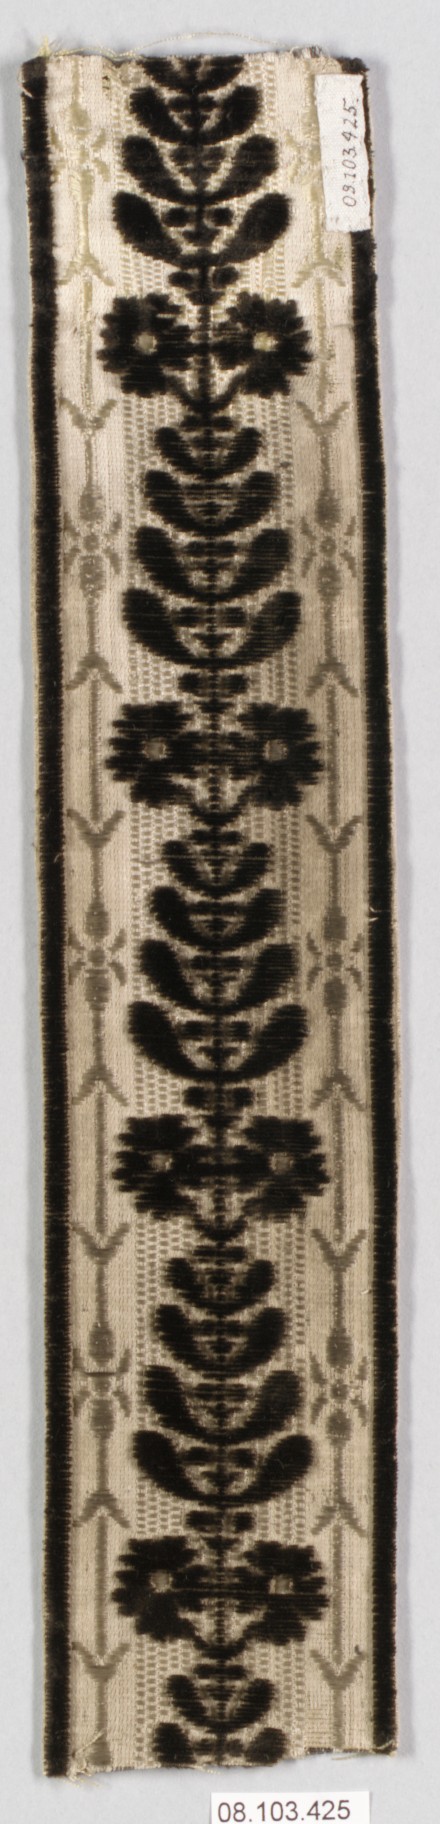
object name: galloon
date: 1801-1900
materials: silk